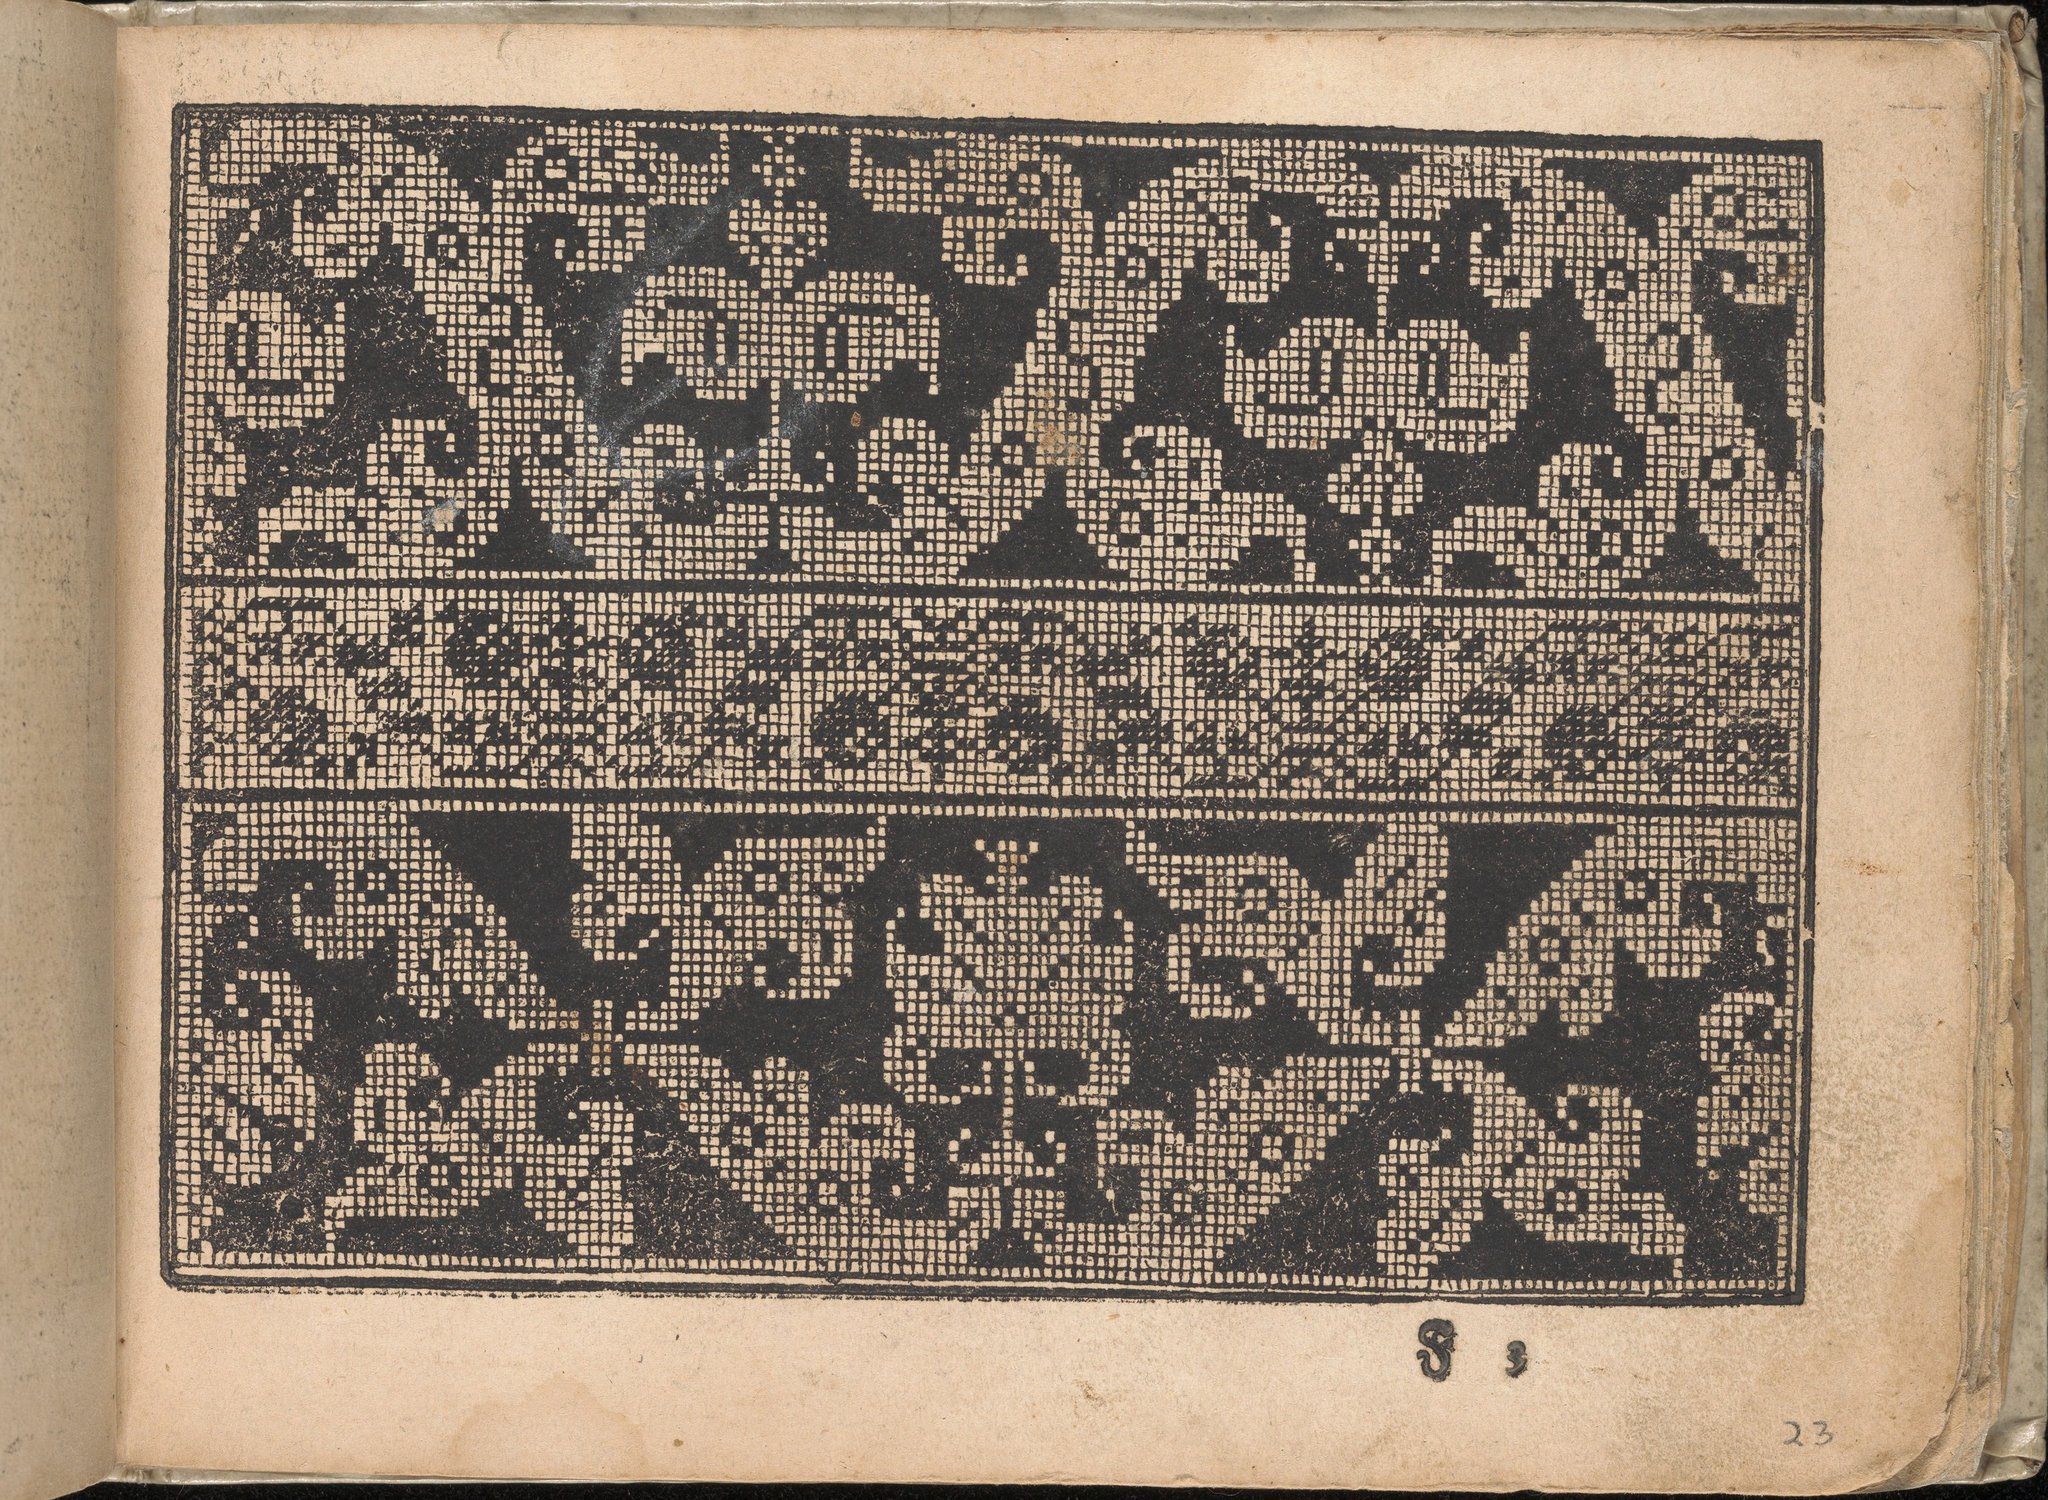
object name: book print ornament architecture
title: Neu künstlich Modelbuch (page 23r)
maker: bernhard jobin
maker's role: publisher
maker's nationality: swiss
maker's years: 1535-1597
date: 1598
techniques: woodcut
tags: ornament